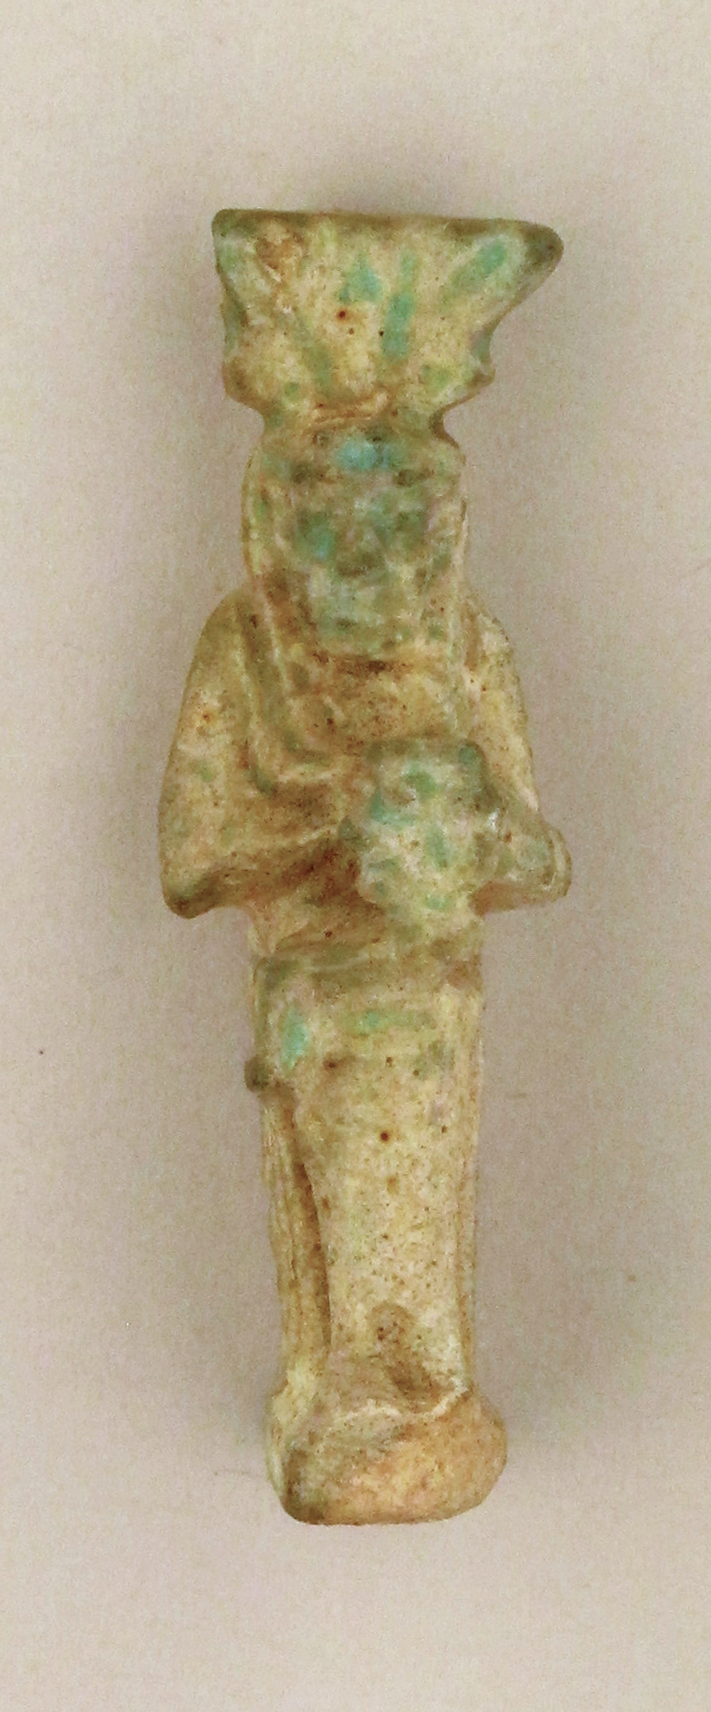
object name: amulet, taweret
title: Faience amulet of Taweret ?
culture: egyptian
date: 664-334 BCE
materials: faience